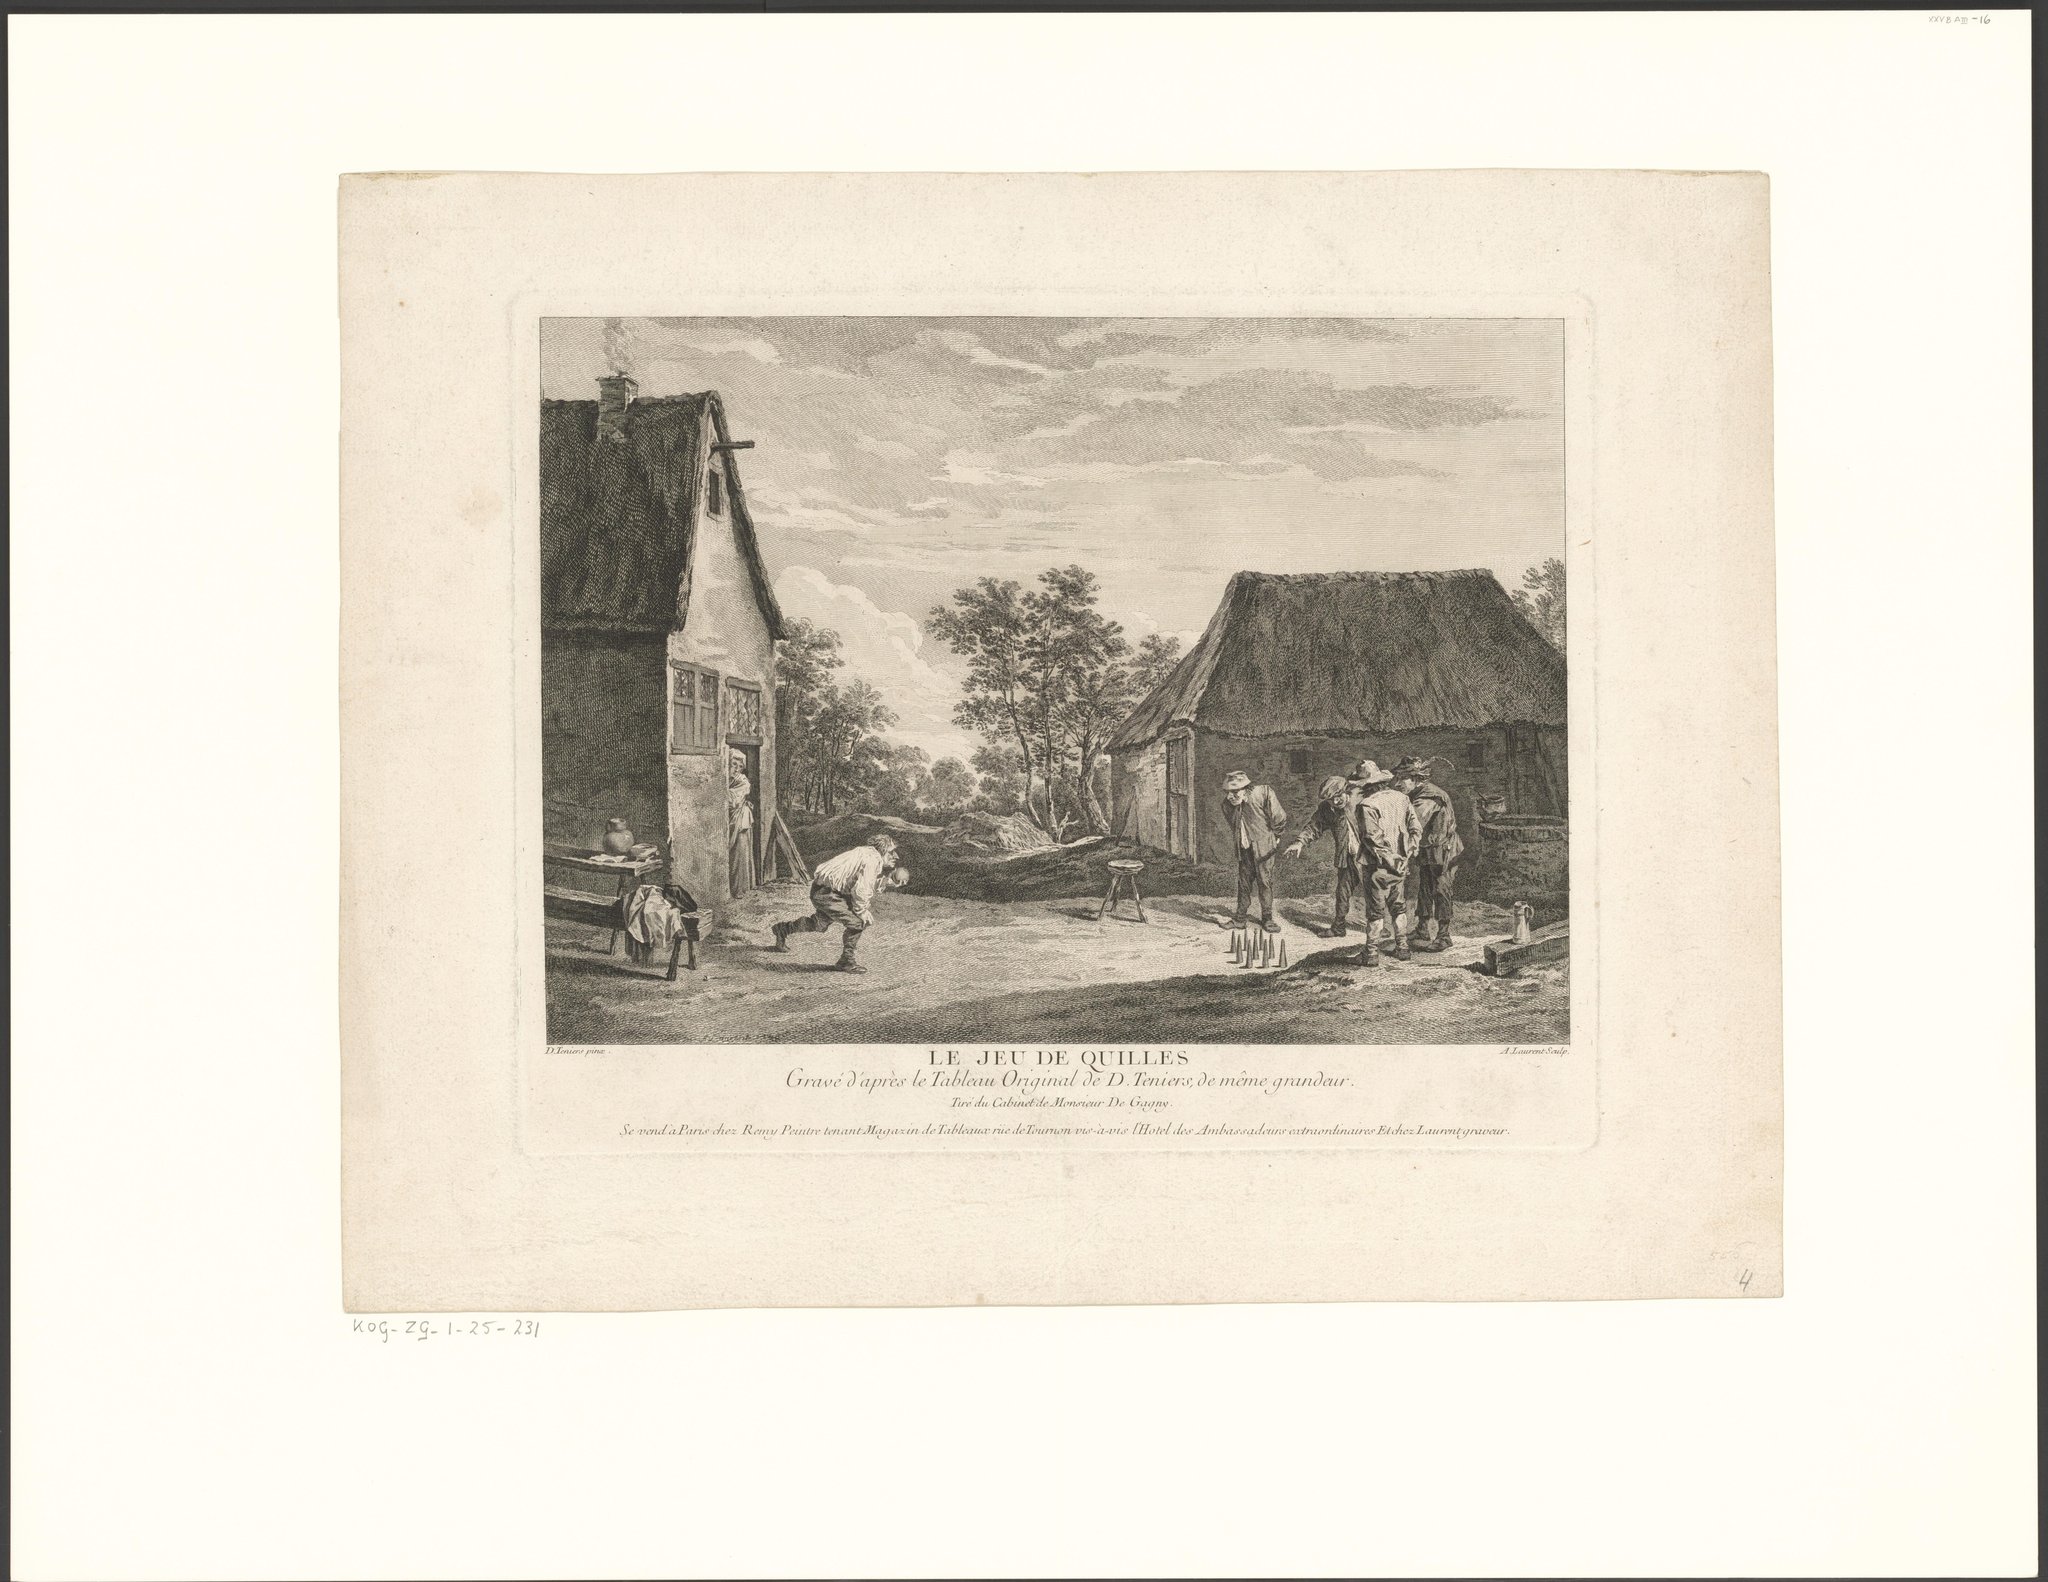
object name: print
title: Groep boeren kegelen buiten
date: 1743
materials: paper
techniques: engraving, etching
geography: paris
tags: sports, games and physical performances, ninepins, skittles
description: Groep boeren kegelen buiten. Een vrouw kijkt toe vanuit de deurpost. Onderwerpsrubrieken binnen de Atlas Zeden en Gewoonten: Zeden en Gewoonten in Engeren Zin, Spel en vermaak, Oud-Hollandsch volksspel, Kegelen.